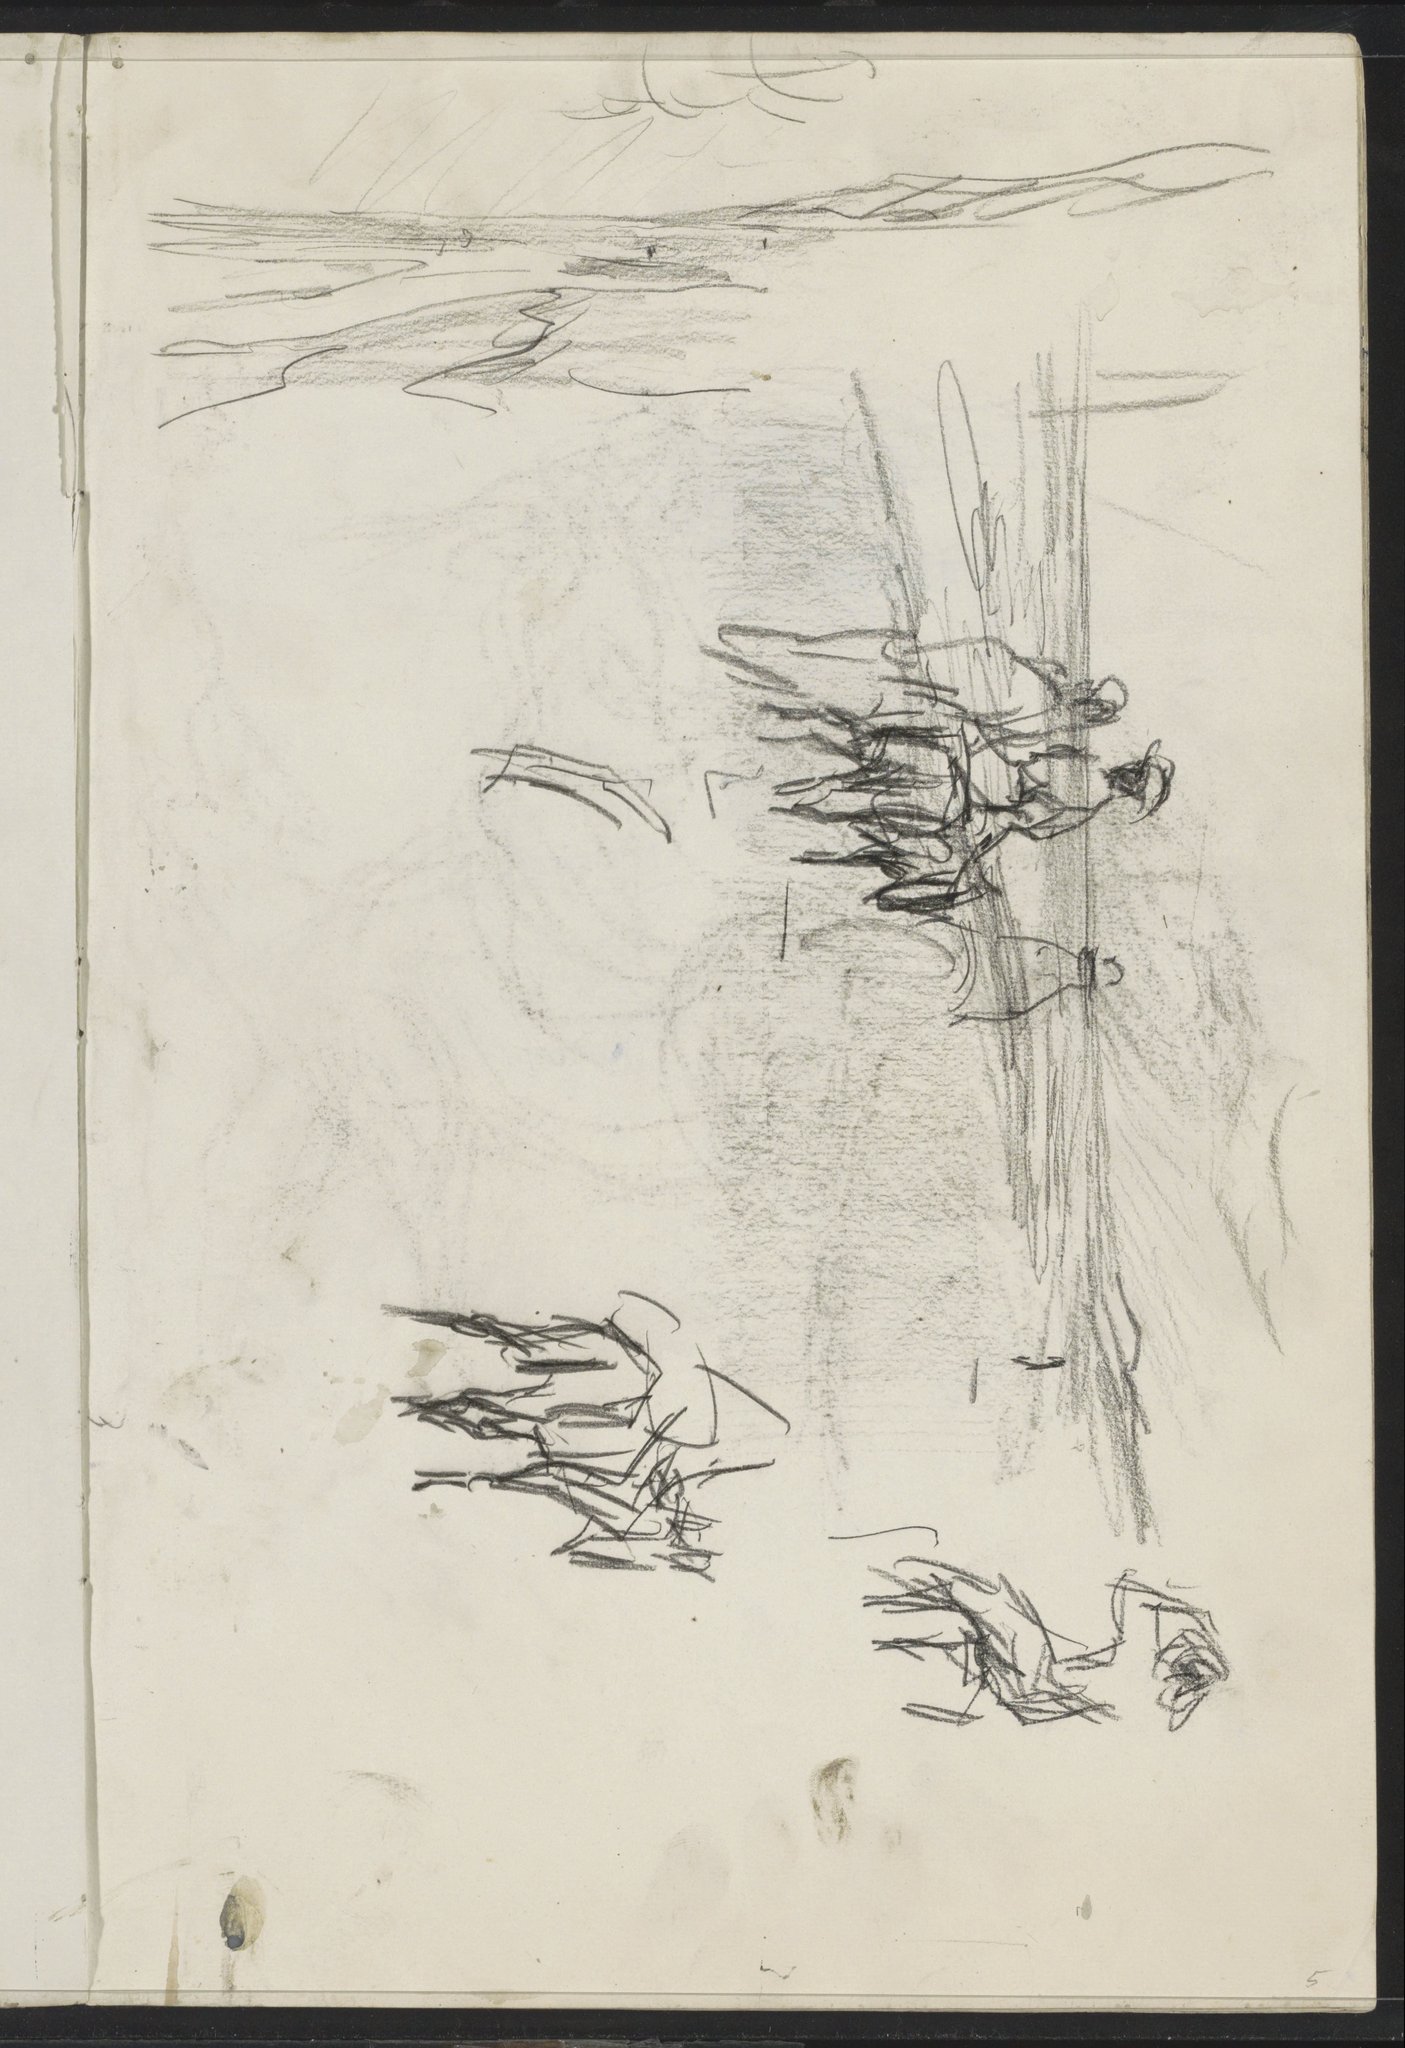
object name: sketchbook leaf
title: Ezelrijdende vrouwen op het strand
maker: isaac israels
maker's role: draughtsman, painter, print maker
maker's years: 1865-1934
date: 1875-1934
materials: chalk, paper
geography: the hague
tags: adolescent, young woman, maiden, donkey-riding (on the beach)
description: Blad 5 recto uit schetsboek LXIX met 25 bladen.